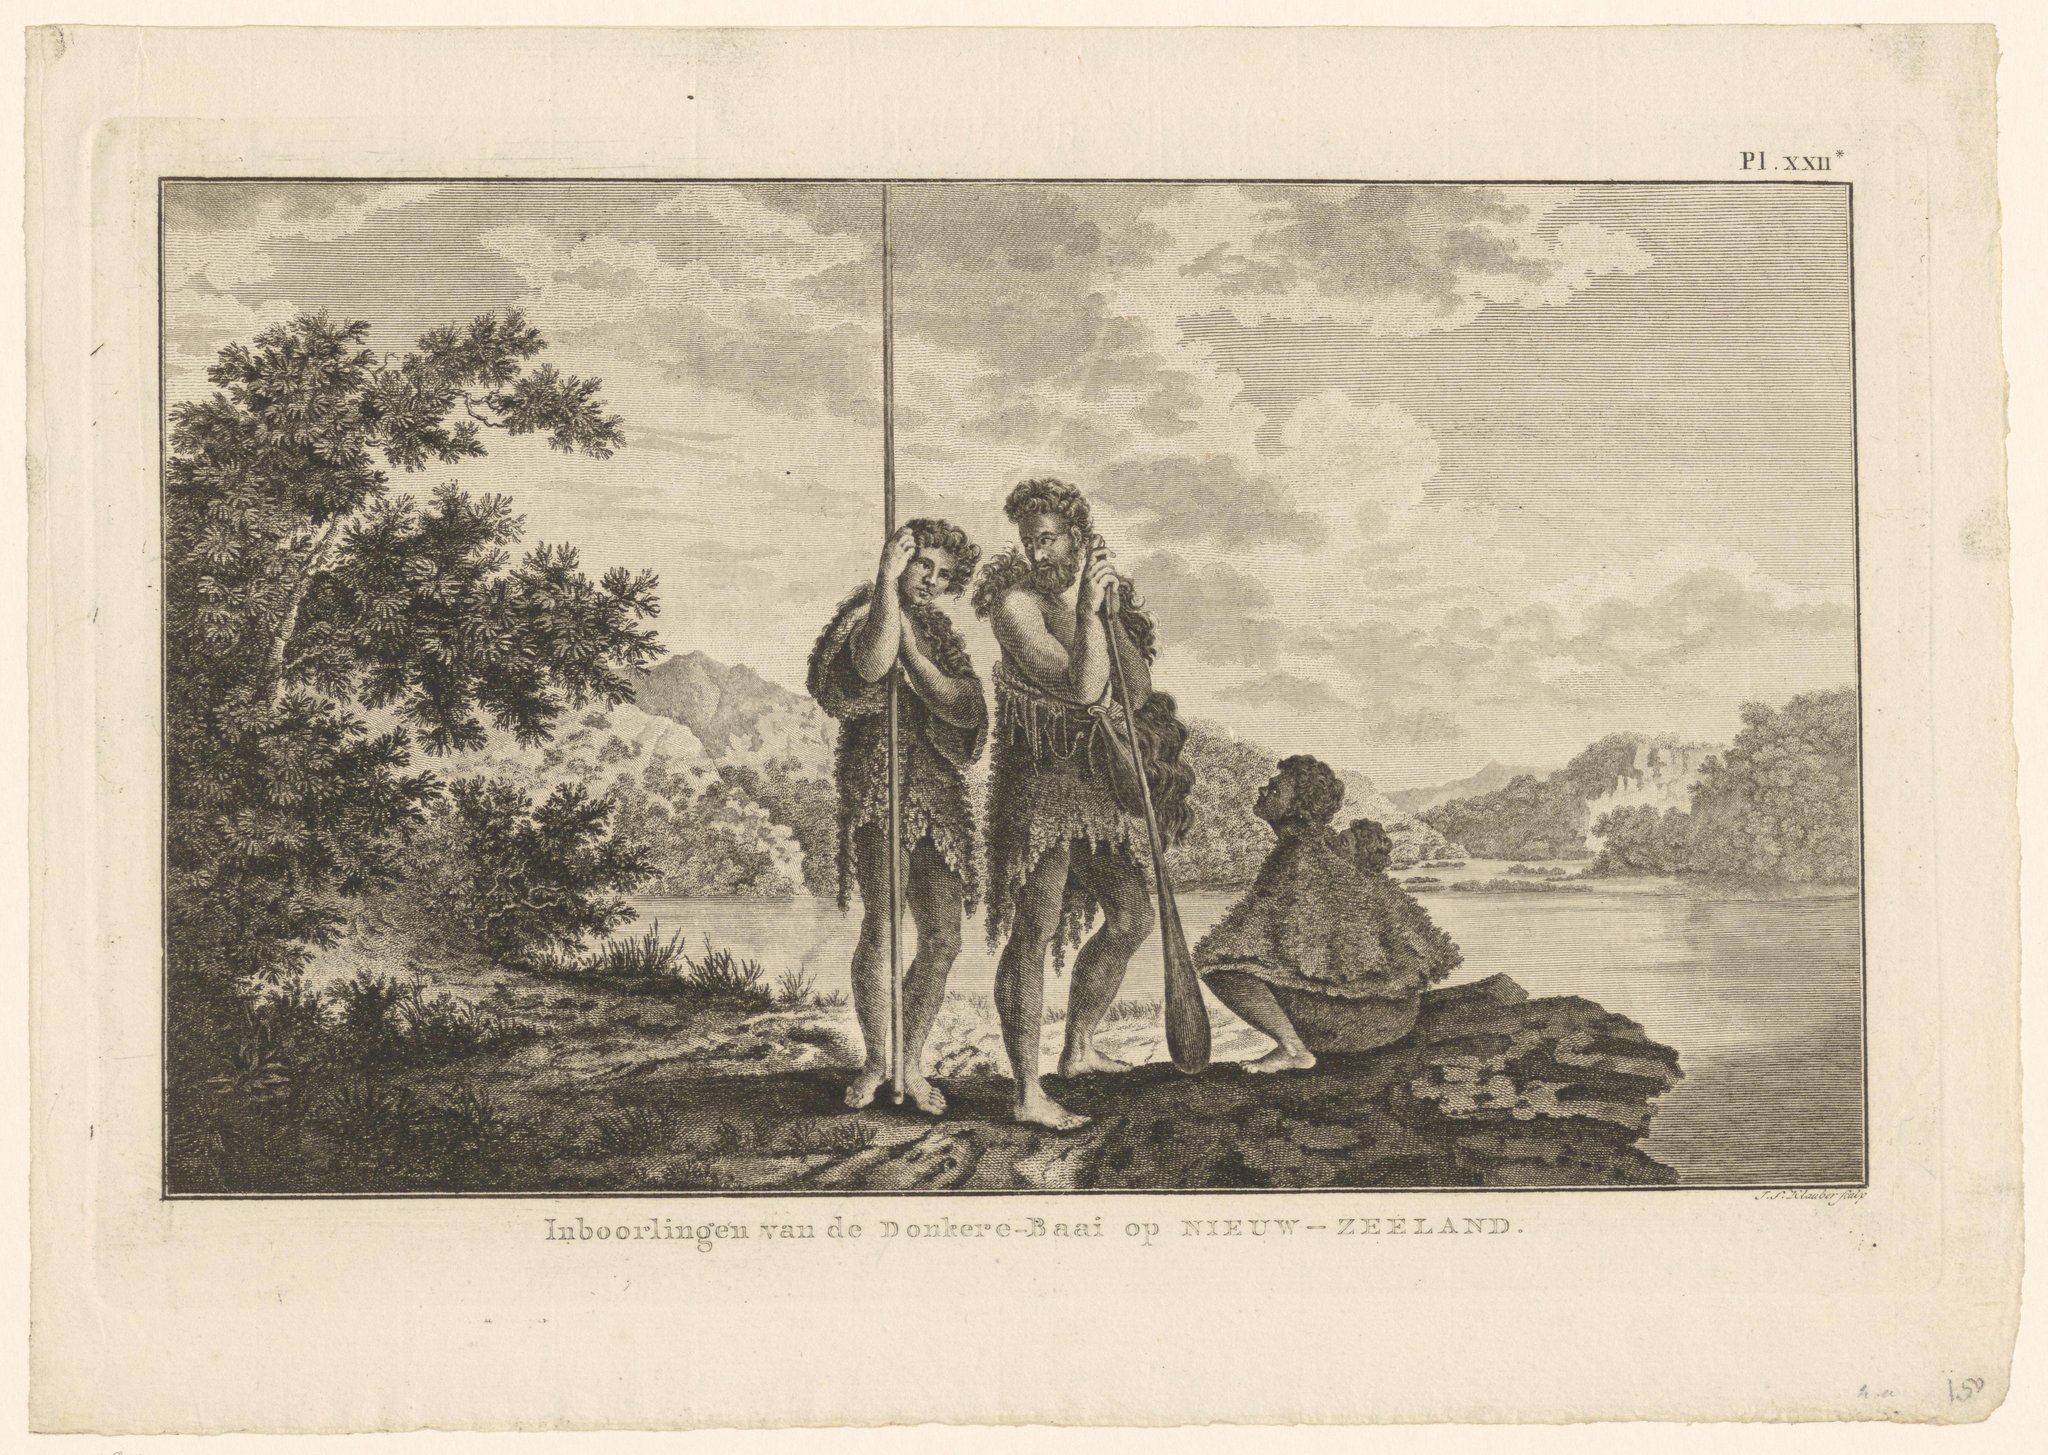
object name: print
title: Drie oorspronkelijke bewoners van Nieuw-Zeeland aan de oever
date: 1797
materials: paper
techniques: engraving, etching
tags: hunter, water course, new zealand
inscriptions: collector's mark: Lugt 2228, number: ‘XXII’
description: Deze prent is mogelijk gebruikt in: Cook, James. Reize rondom de Waereld (...) met kaarten en plaaten. [Vertaald uit het Engels door] Jan David Pasteur. Leiden: Honkoop, Amsterdam: Allart, Den Haag: Van Cleef, 1797, dl. 6.